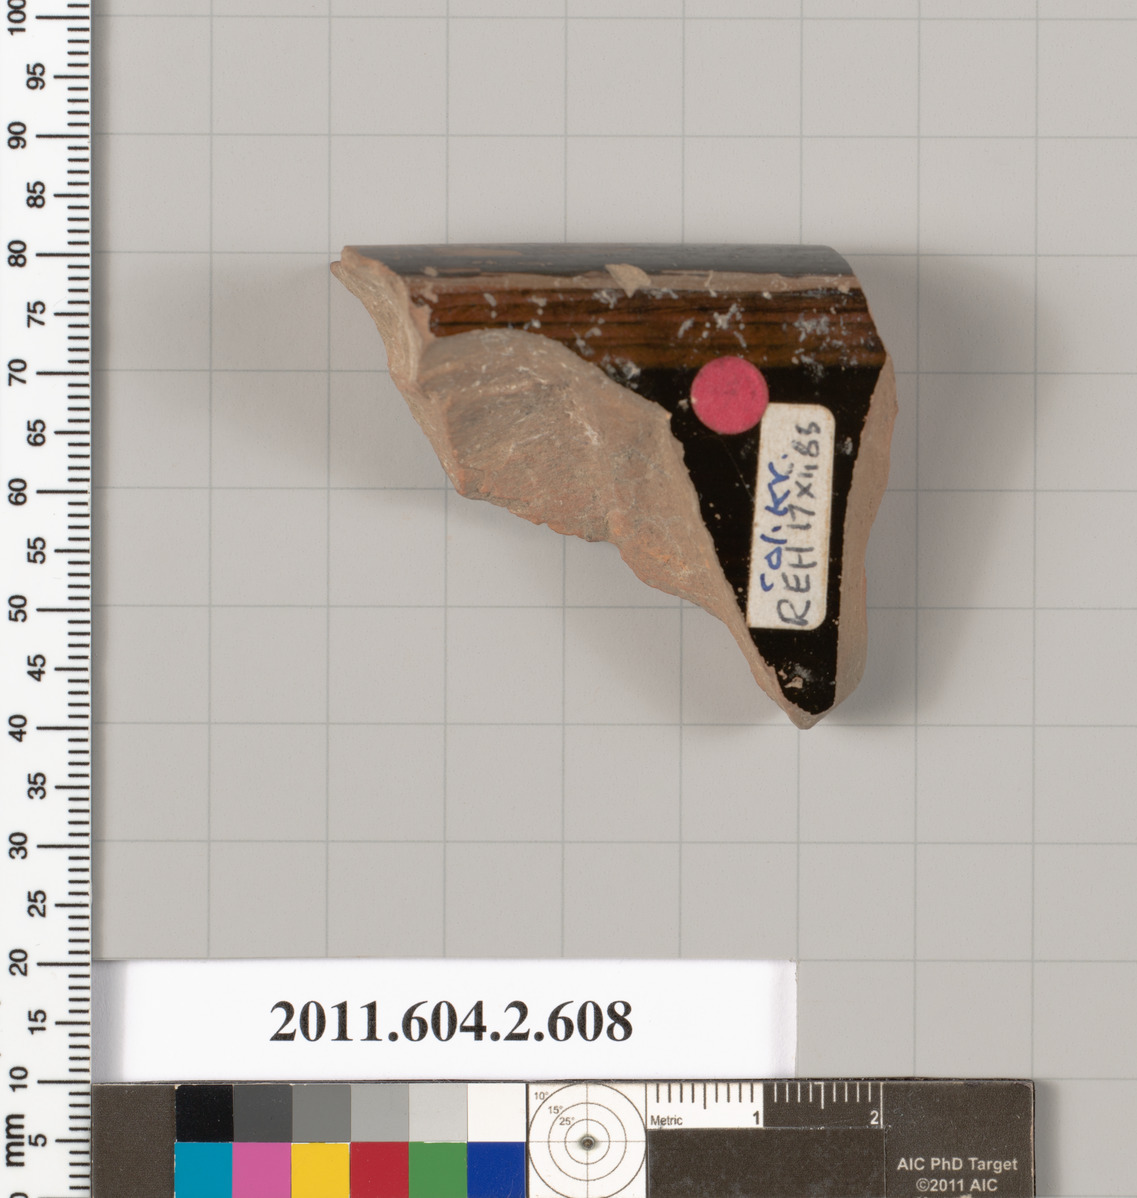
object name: column krater fragment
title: Terracotta fragment of a column-krater (bowl for mixing wine and water)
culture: greek, attic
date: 475-451 BCE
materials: terracotta